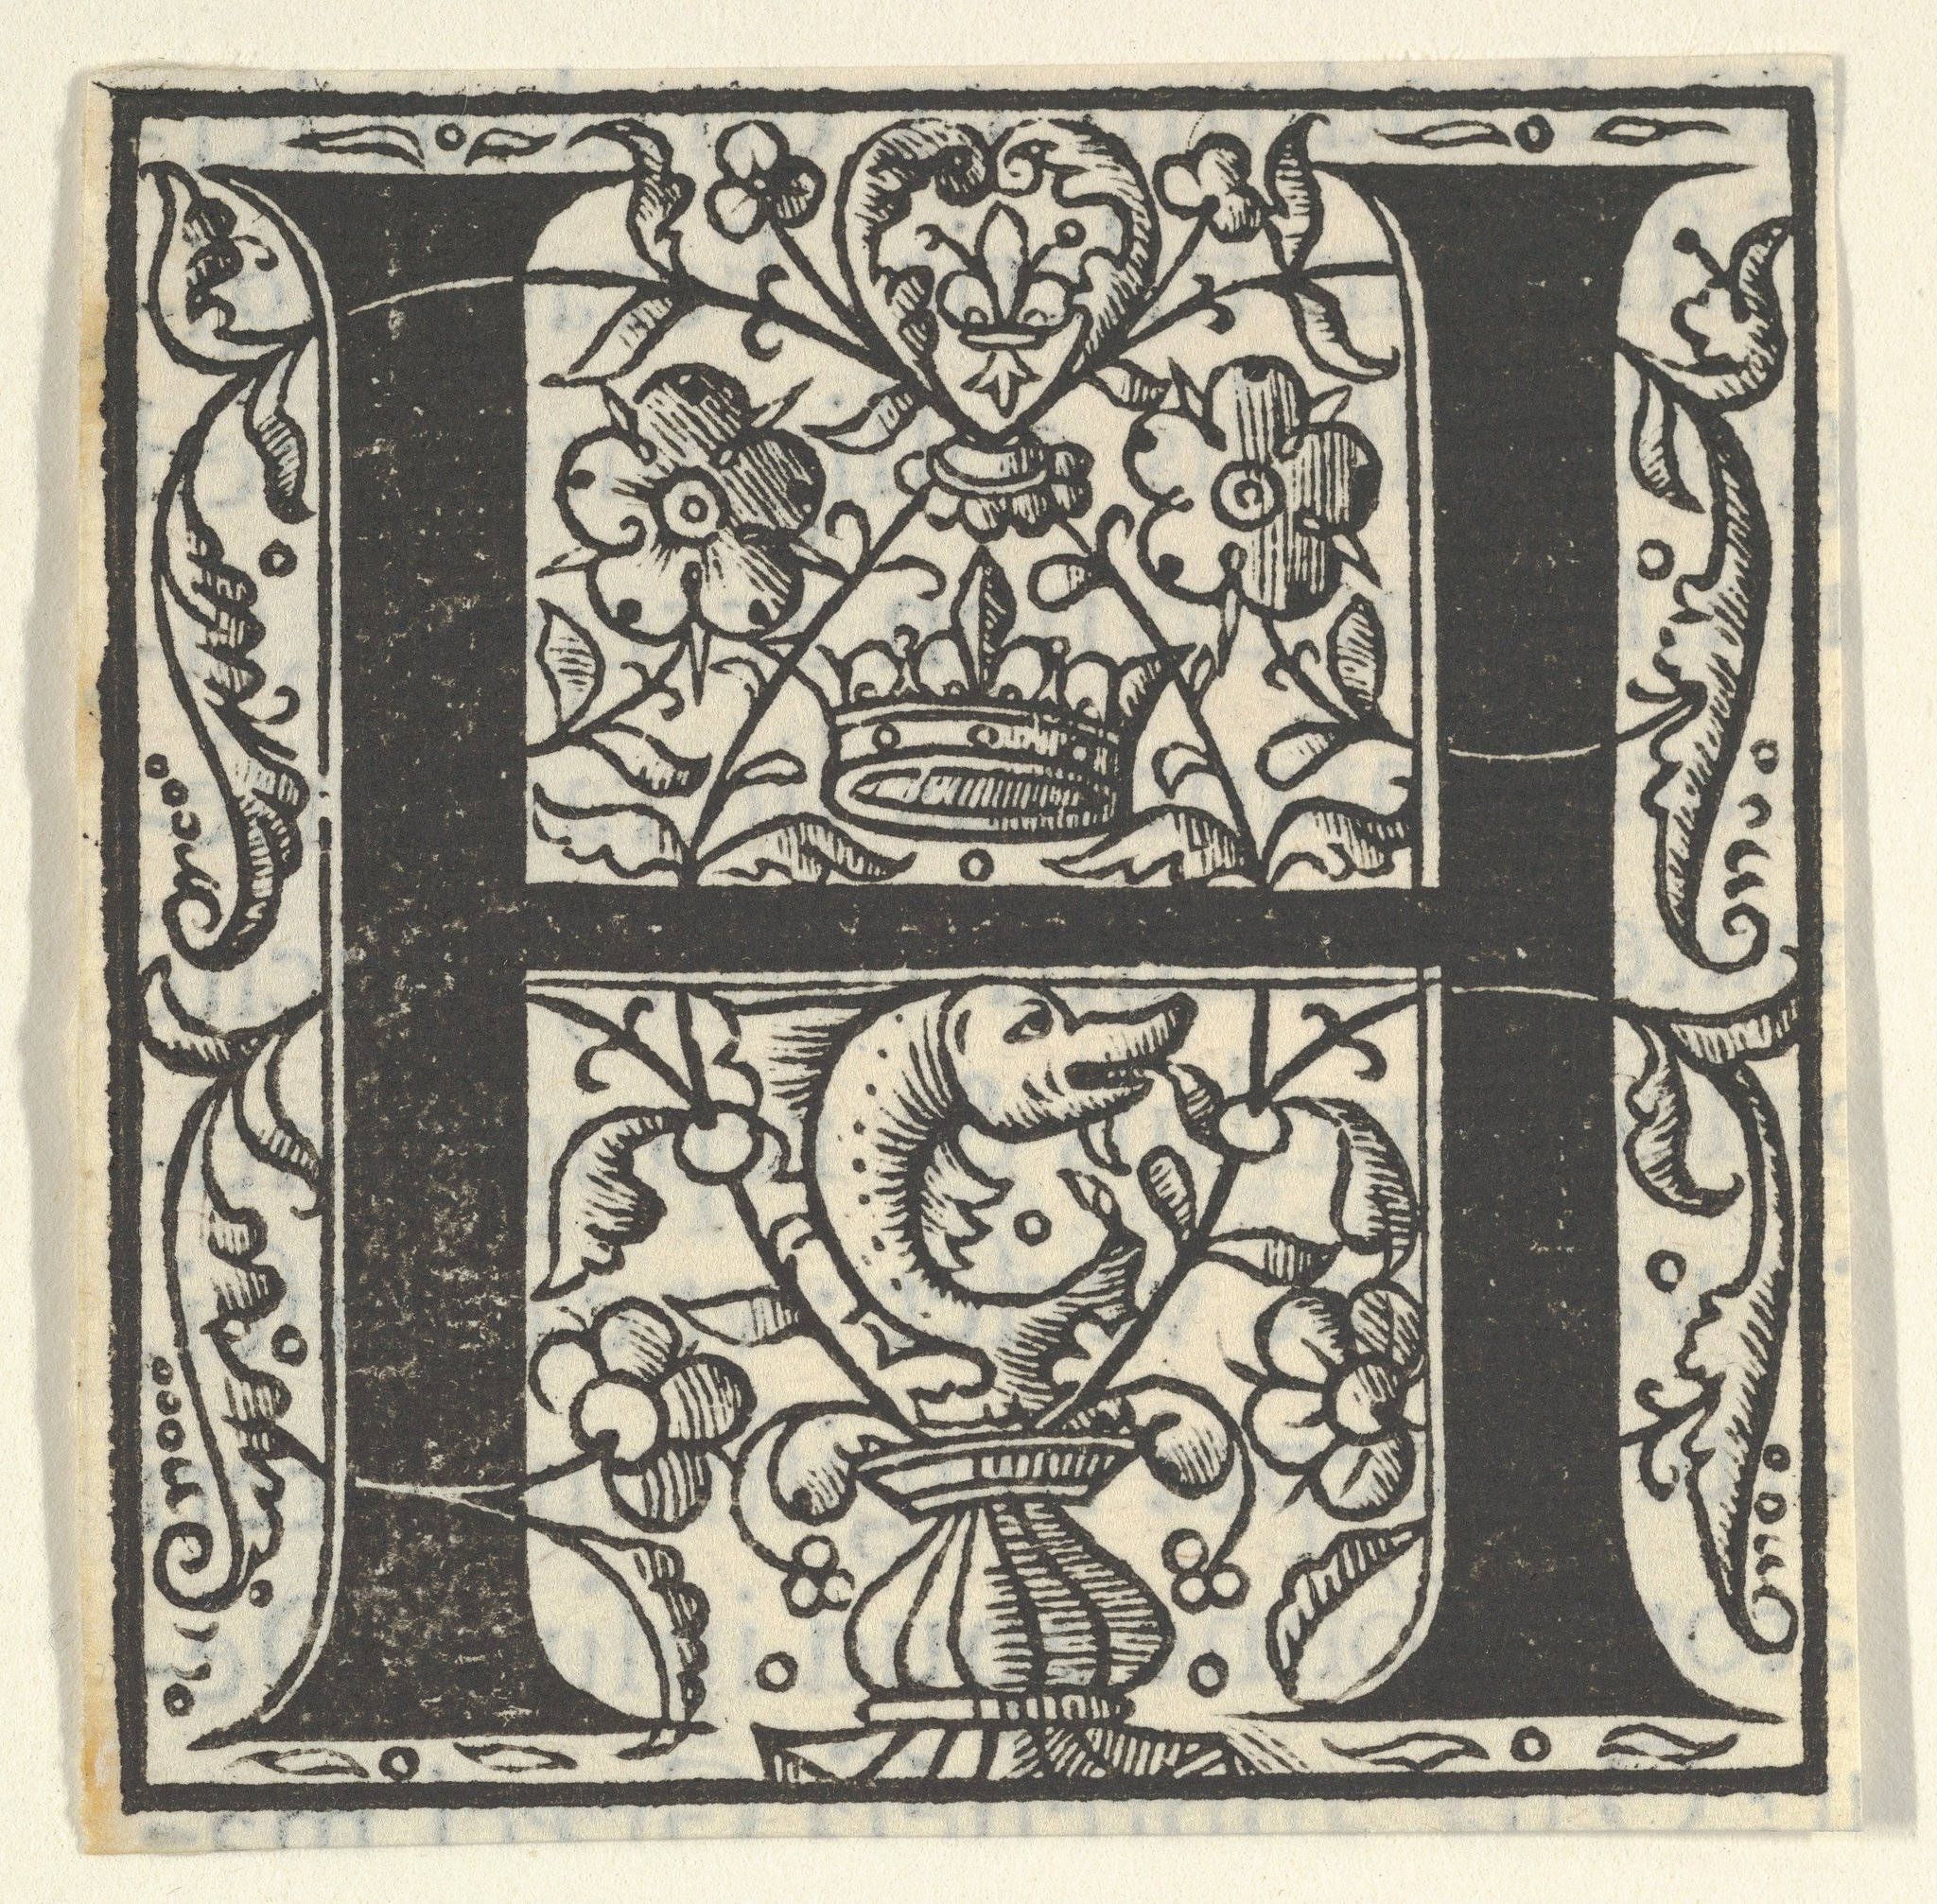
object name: print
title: Initial letter H with dolphin and crown (related to King Francis I)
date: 1534-1566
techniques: woodcut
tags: dolphins,flowers